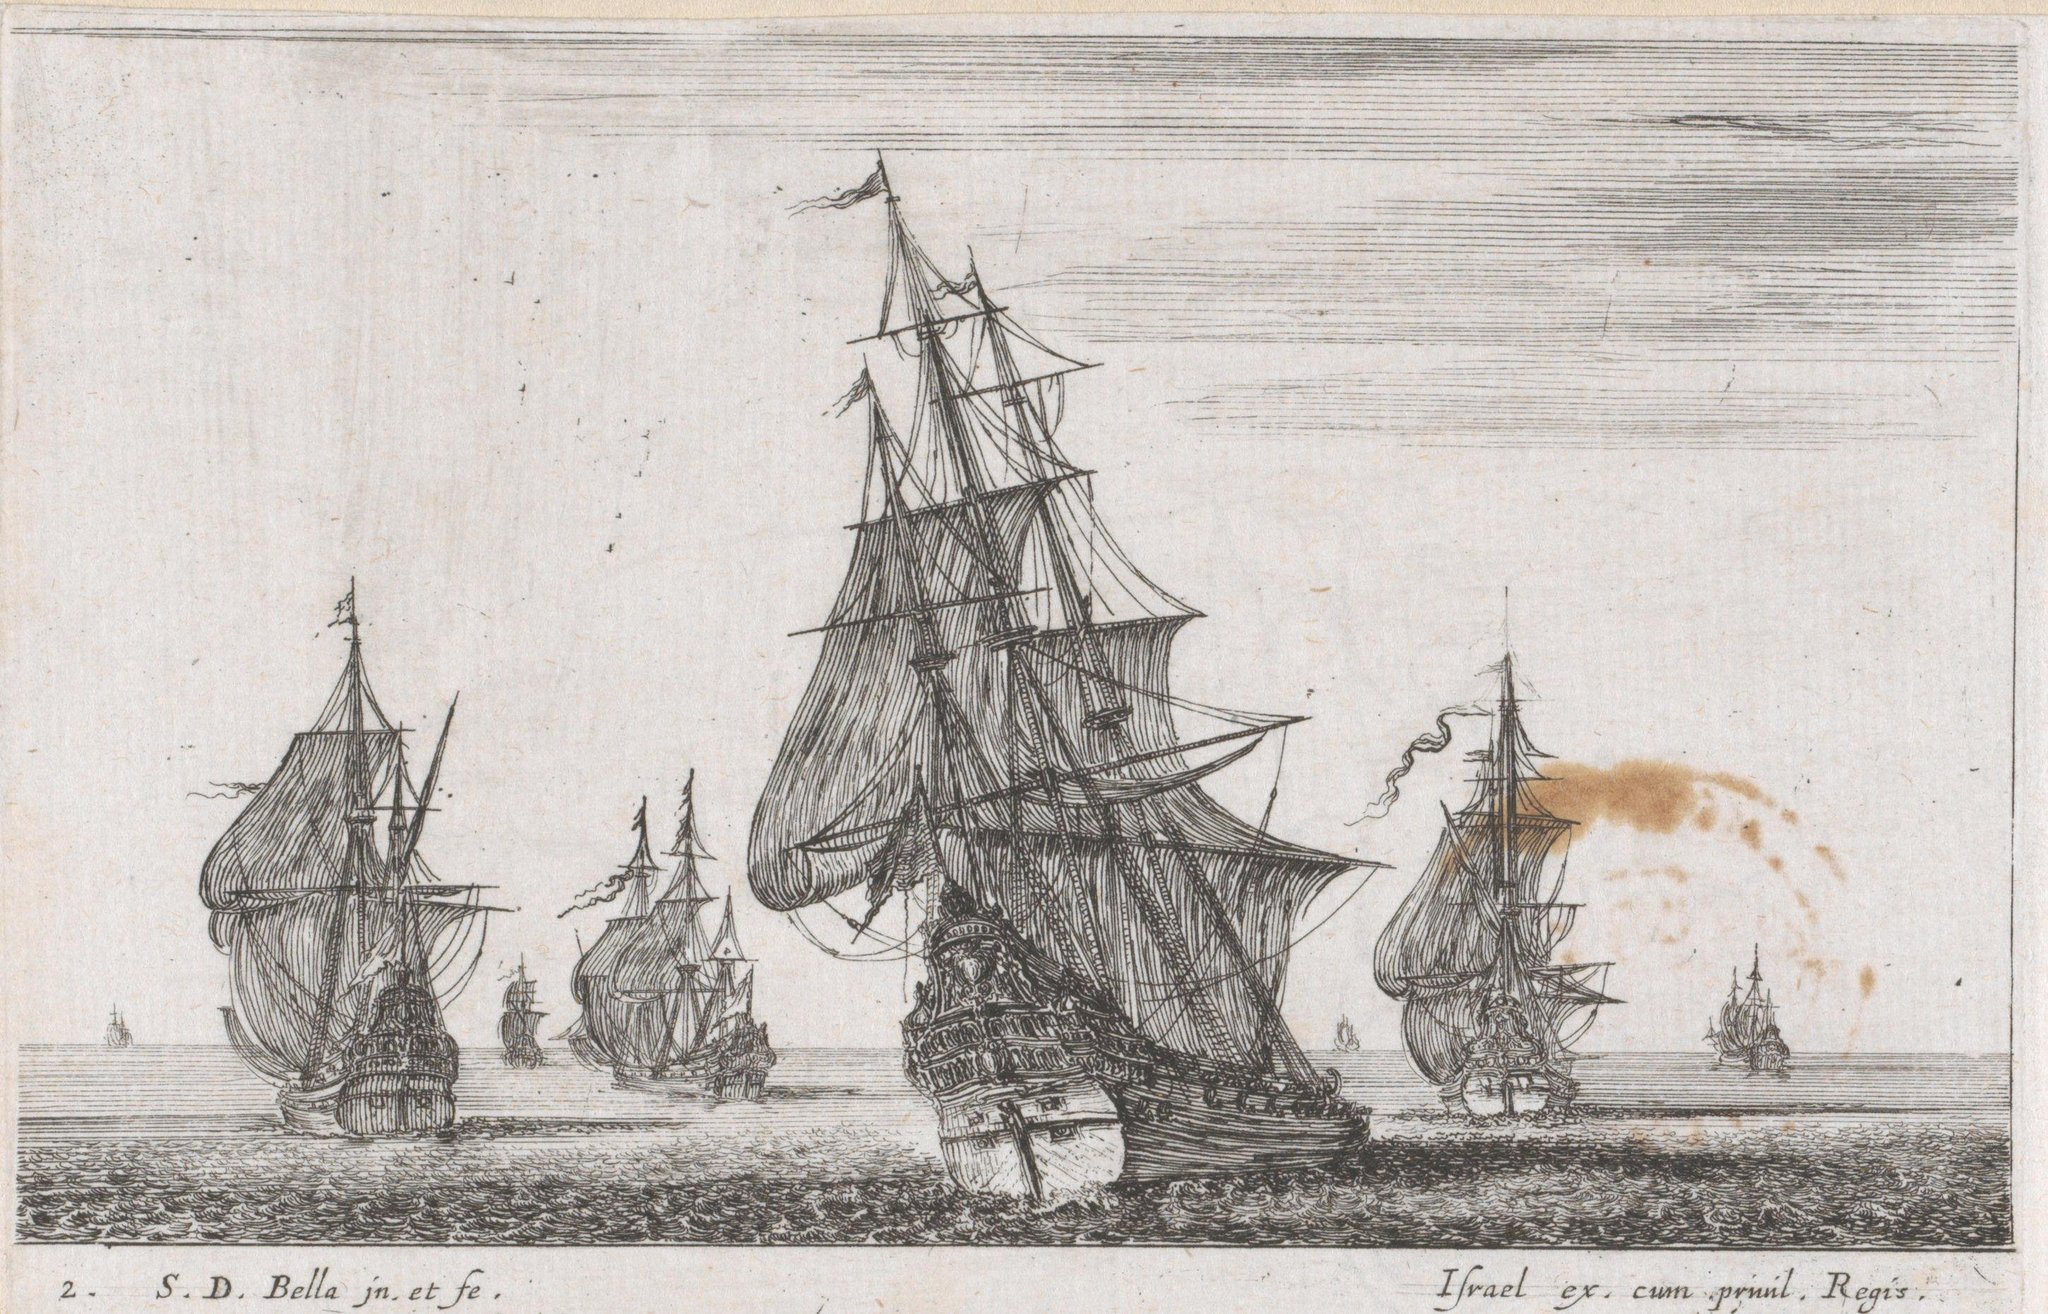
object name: print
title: Acht zeilschepen op zee, van achteren gezien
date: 1620-1664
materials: paper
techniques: etching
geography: france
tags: ships (in general)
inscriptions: collector's mark: Lugt 240